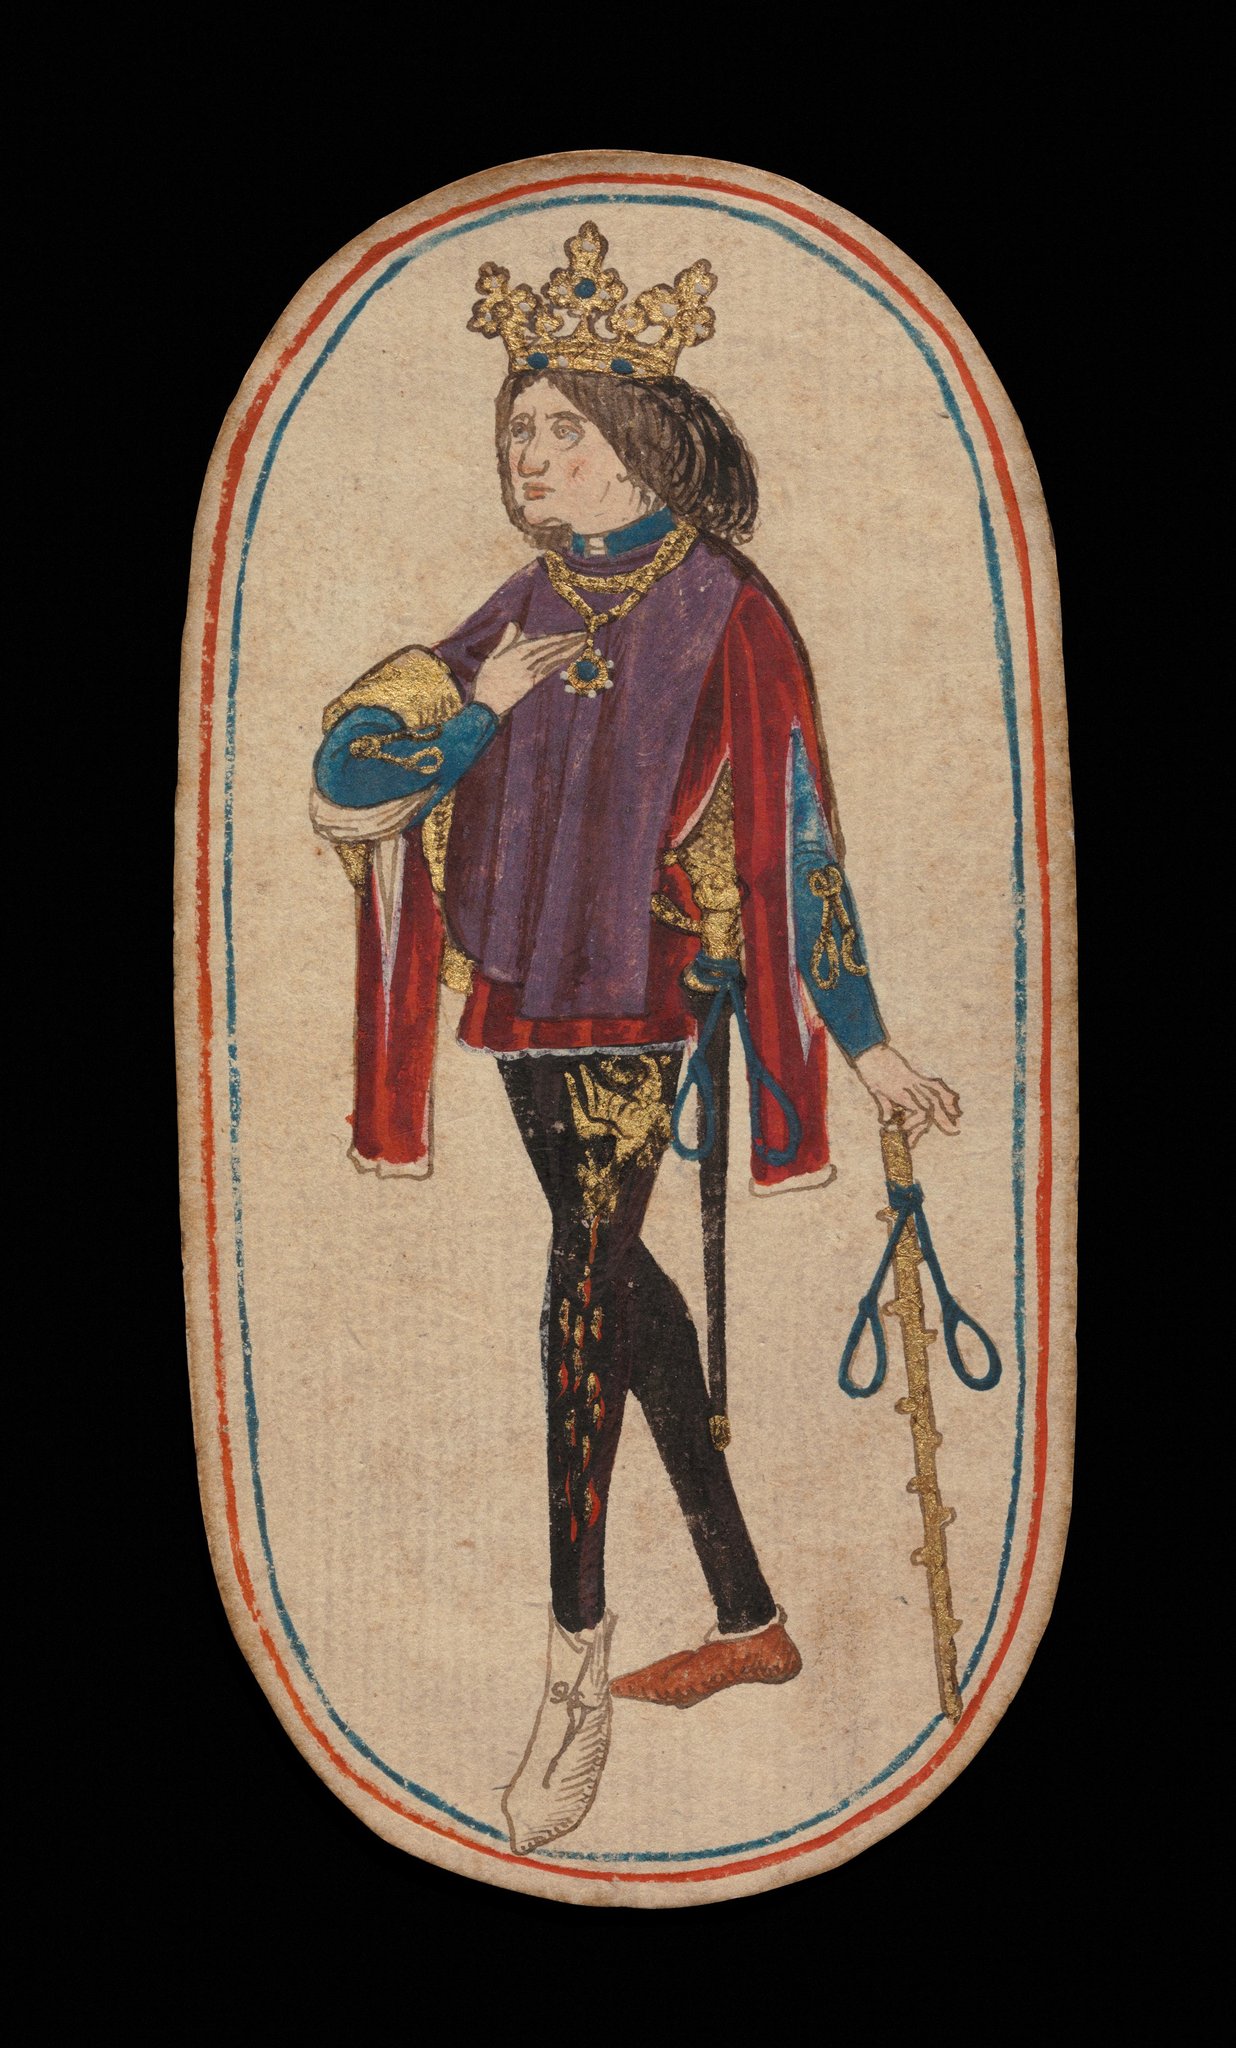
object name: playing card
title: King of Nooses, from The Cloisters Playing Cards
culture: south netherlandish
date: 1475-1480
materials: glaze, gold, ink, paint, paper, silver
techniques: pen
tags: kings,playing cards,games